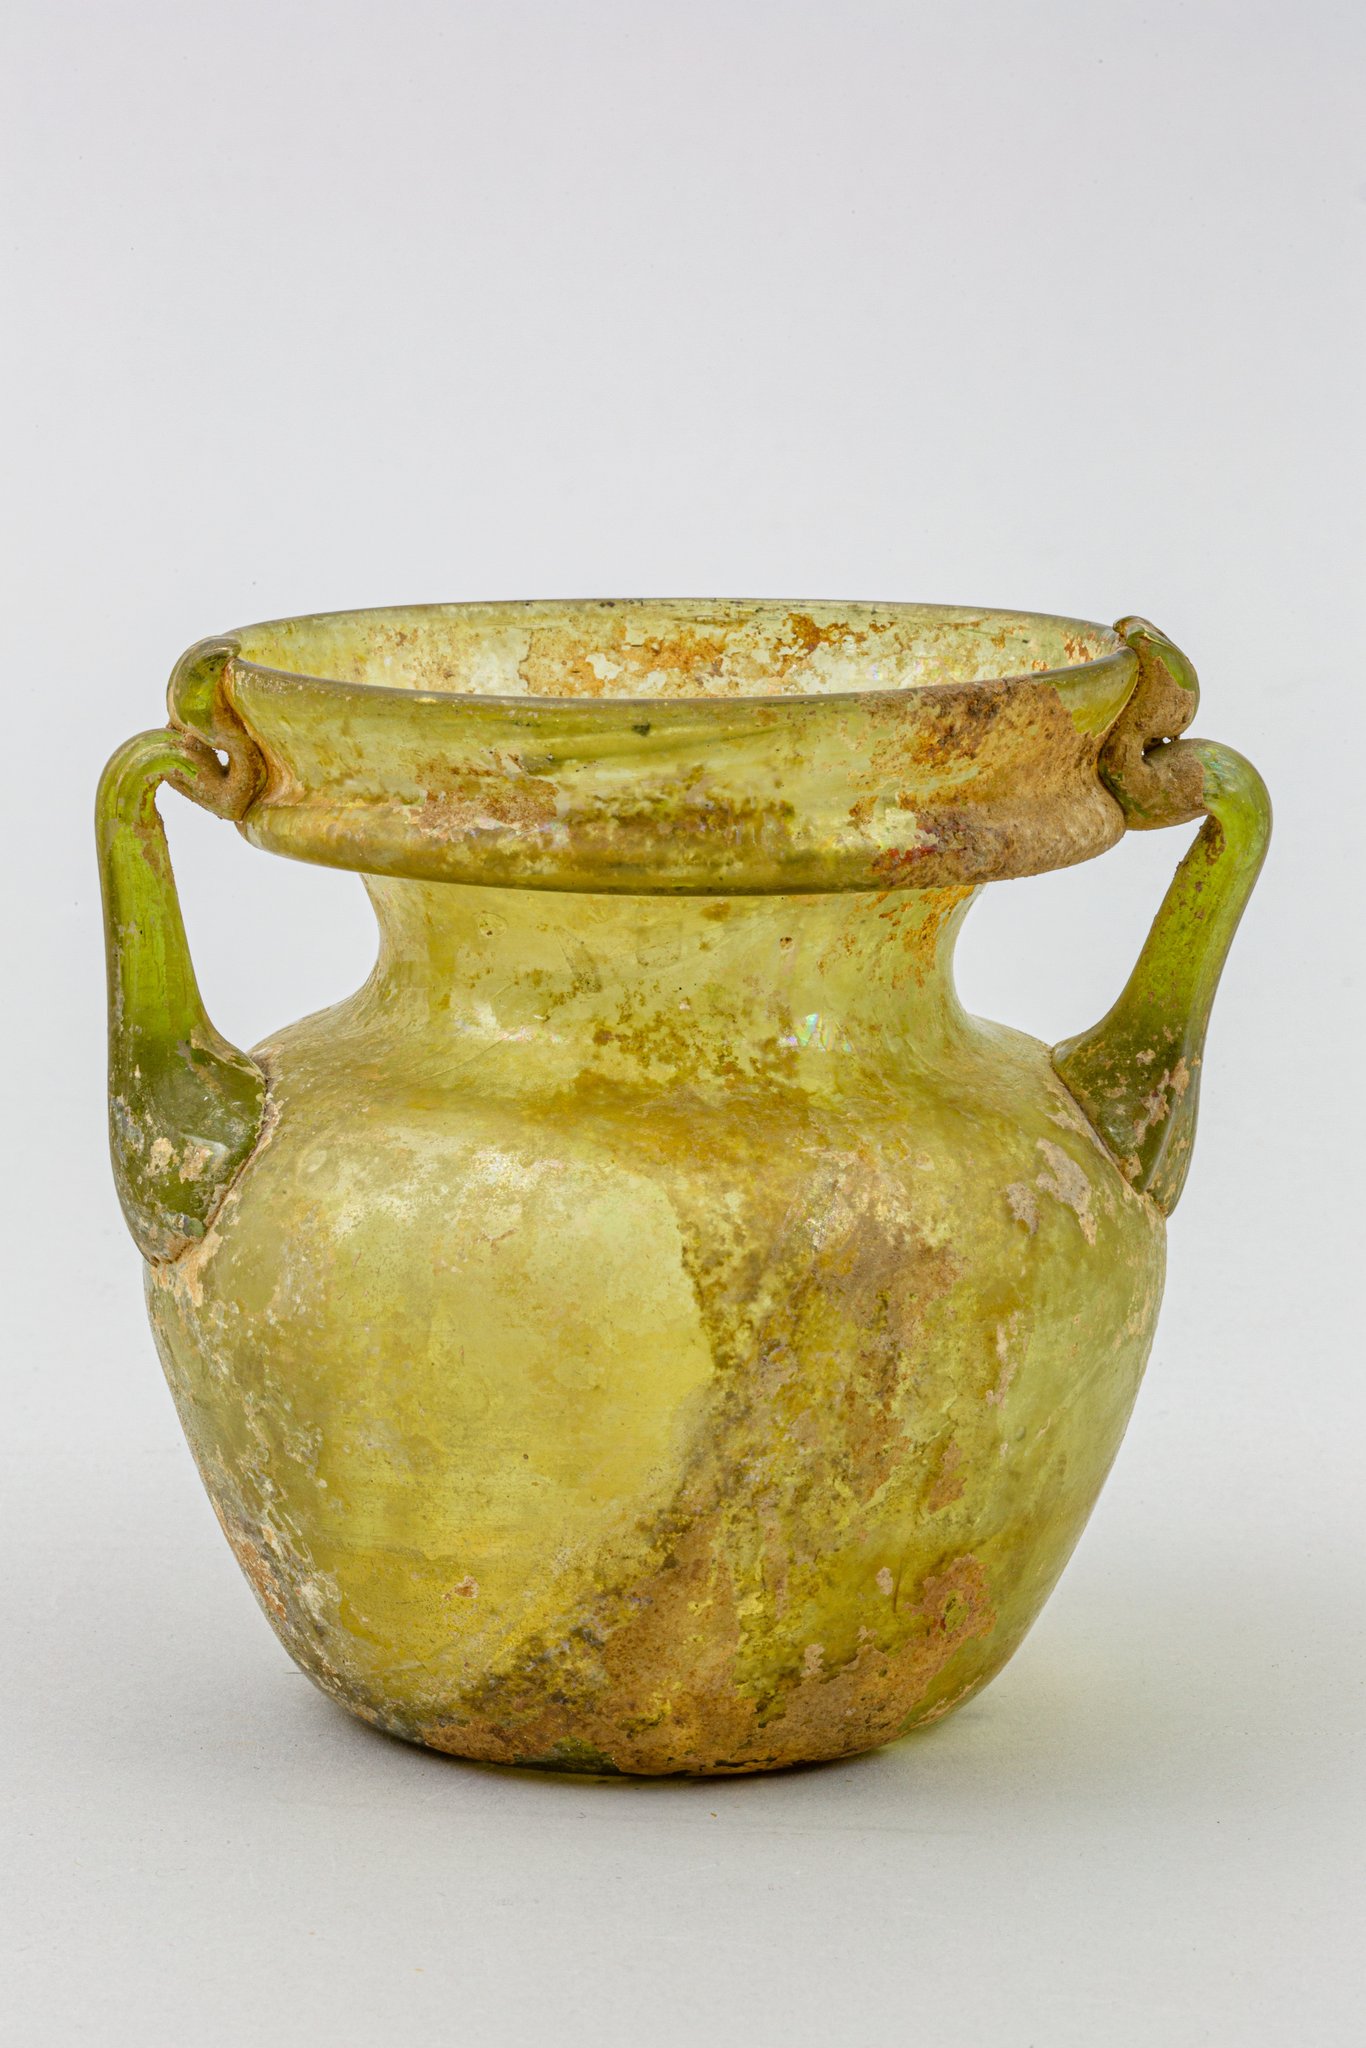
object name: jar, handled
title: Glass jar with two handles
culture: roman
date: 301-500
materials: glass